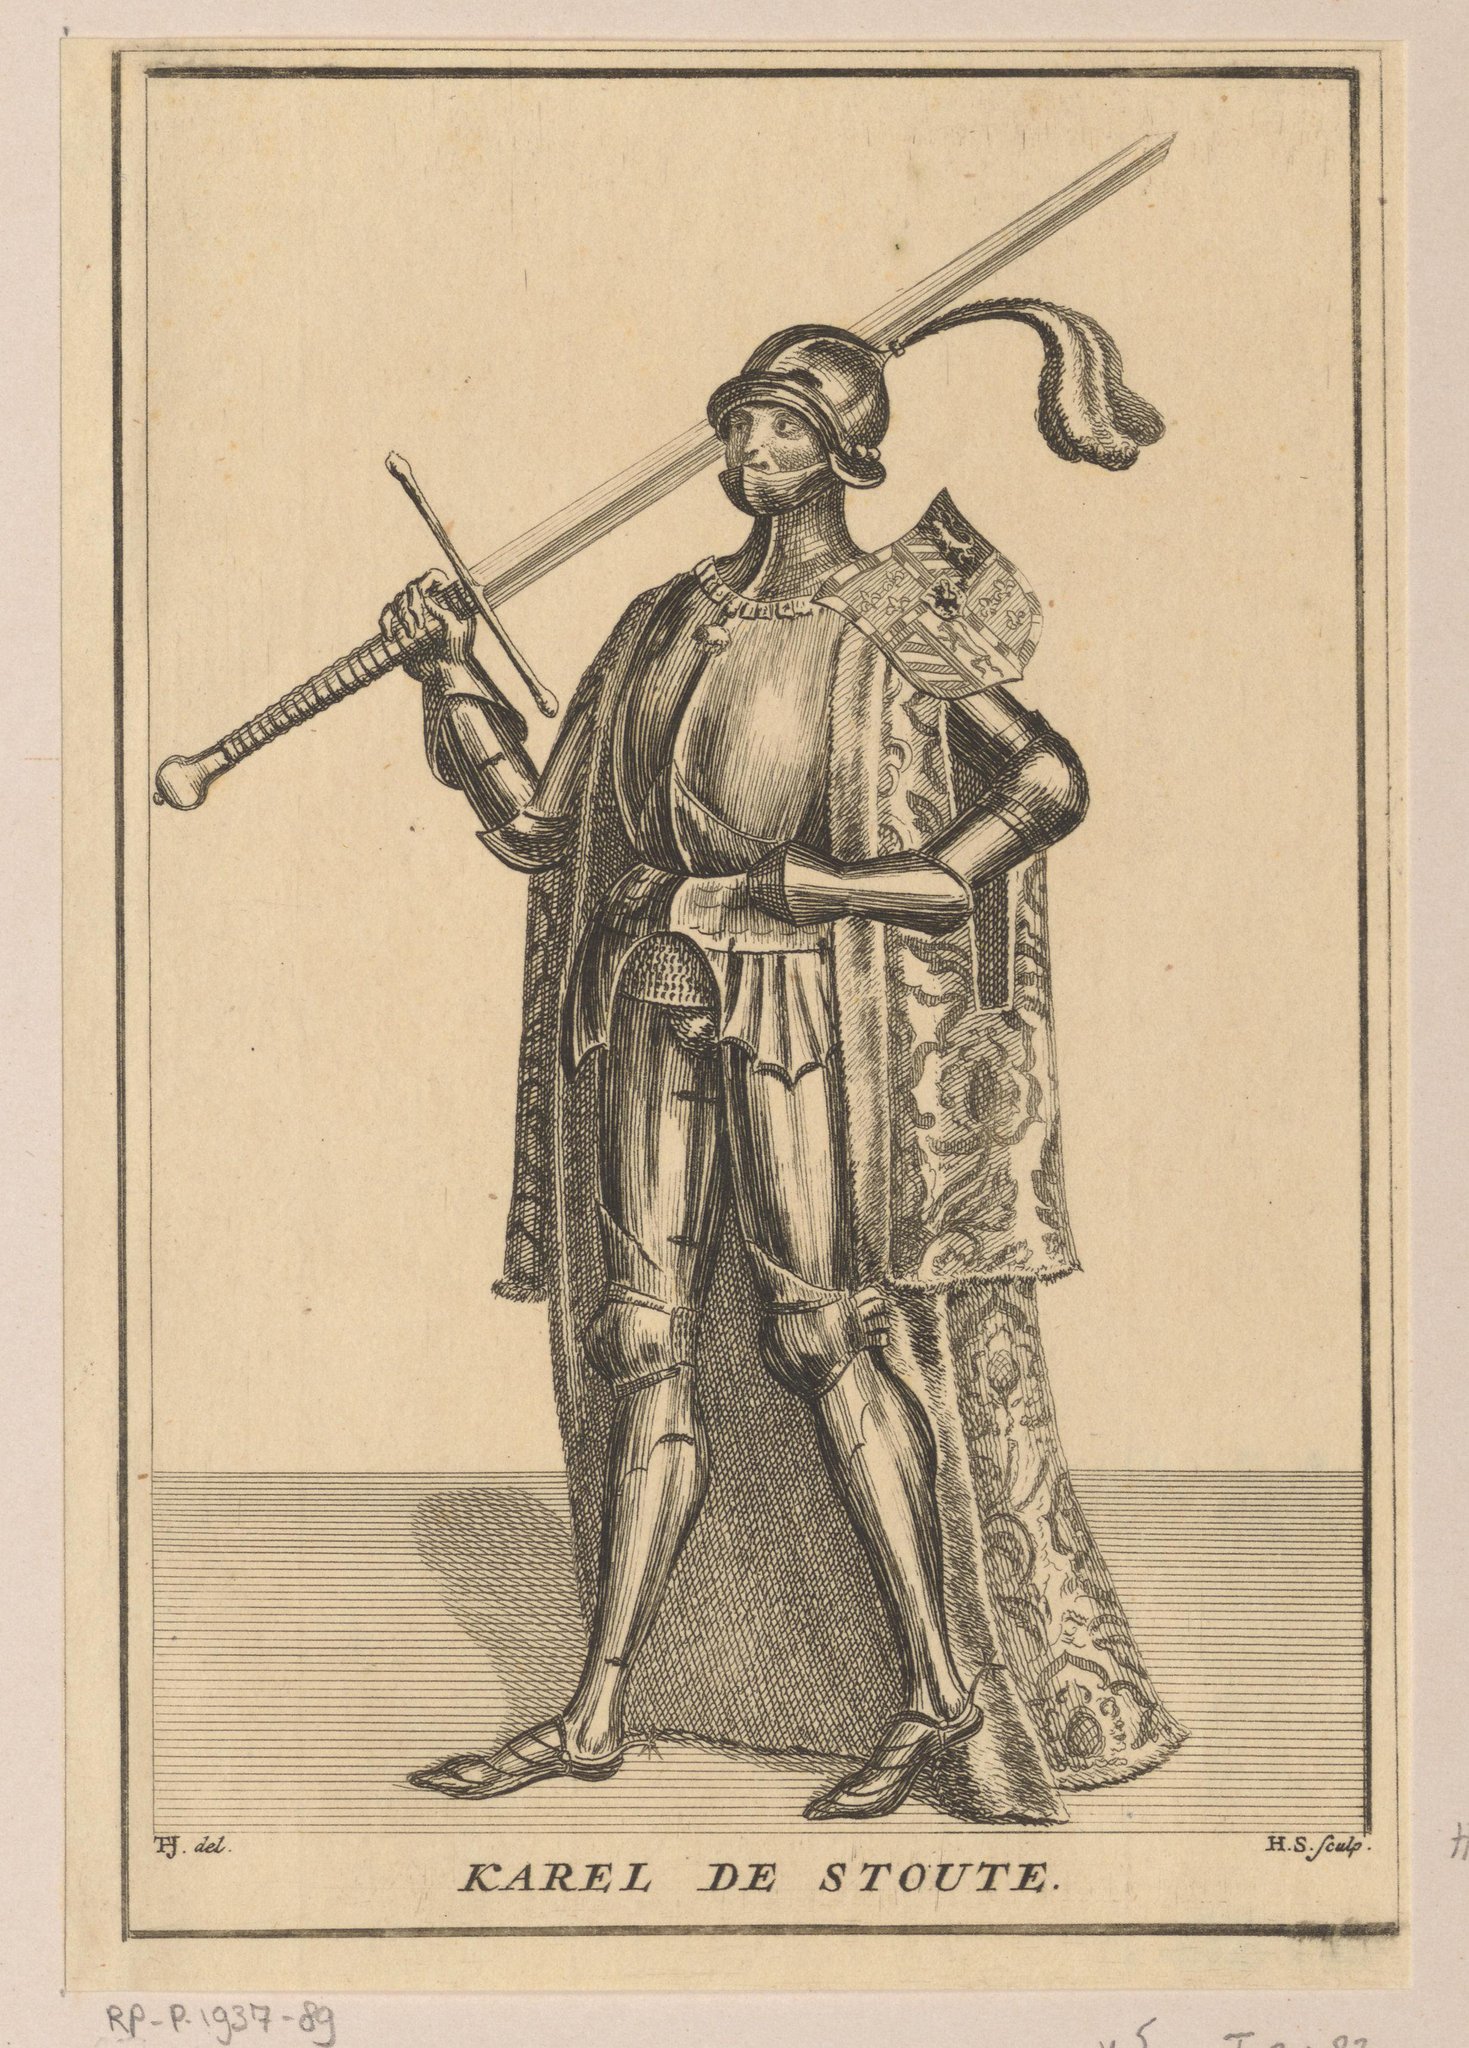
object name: print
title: Portret van Karel de Stoute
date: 1745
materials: paper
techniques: engraving, etching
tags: earl, charles the bold (duke of burgundy), historical persons, knighthood order of the golden fleece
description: Prent mogelijk uit: Langendyk, Pieter. De graaven van Holland (...). Haarlem: J. Bosch, 1745.